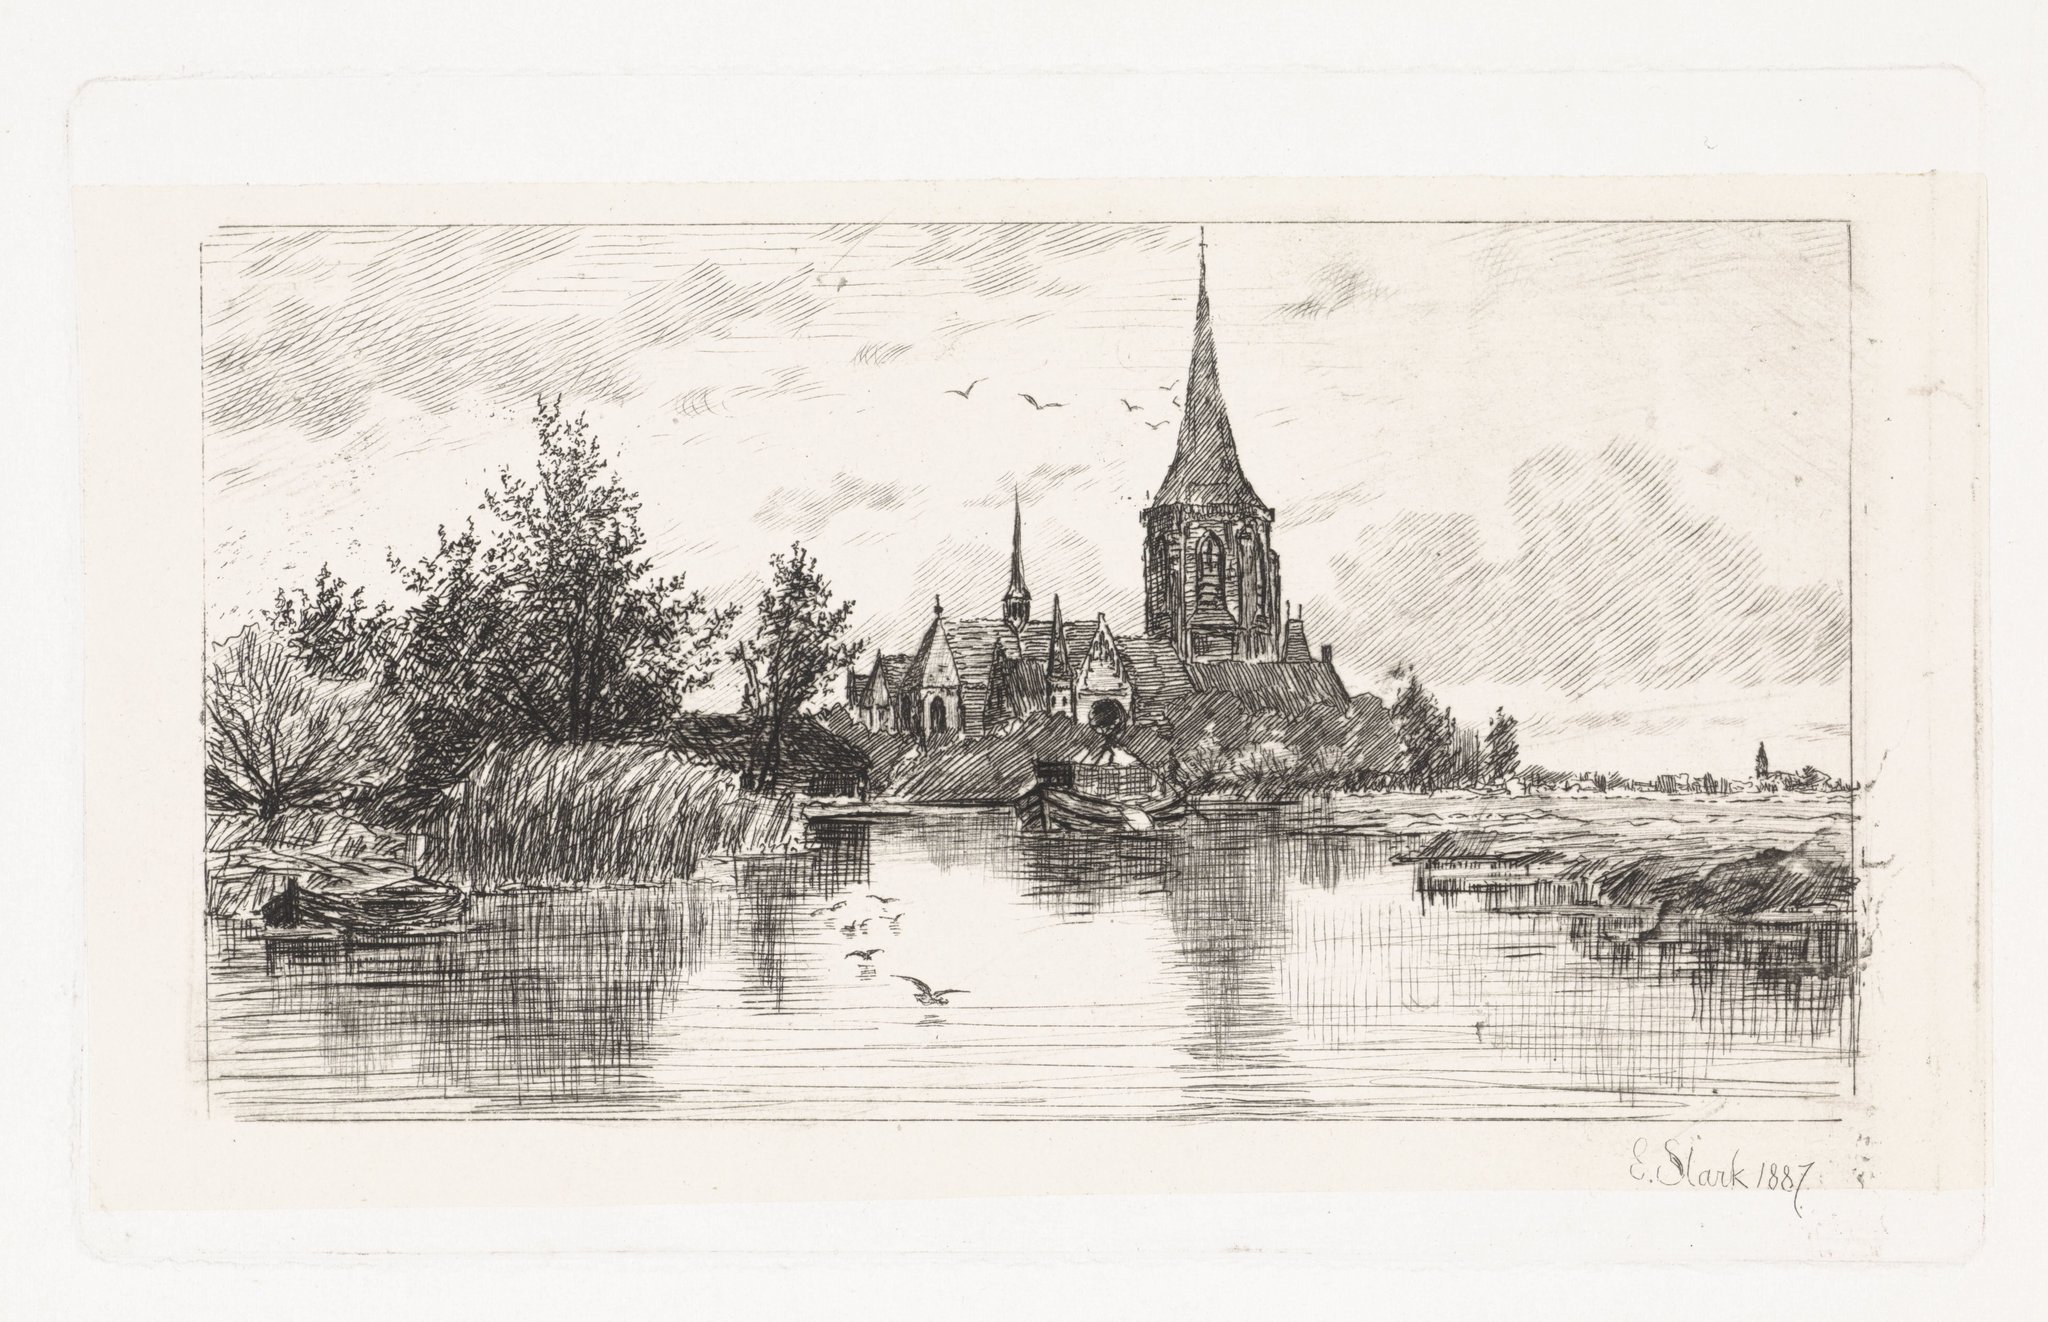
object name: print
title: Sint Urbanuskerk te Bovenkerk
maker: elias stark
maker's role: draughtsman, print maker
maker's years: 1849-1933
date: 1887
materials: paper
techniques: aquatint, etching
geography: nieuwer-amstel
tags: church (exterior)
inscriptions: collector's mark: Lugt 2228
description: De St. Urbanuskerk te Bovenkerk gezien vanaf het water.